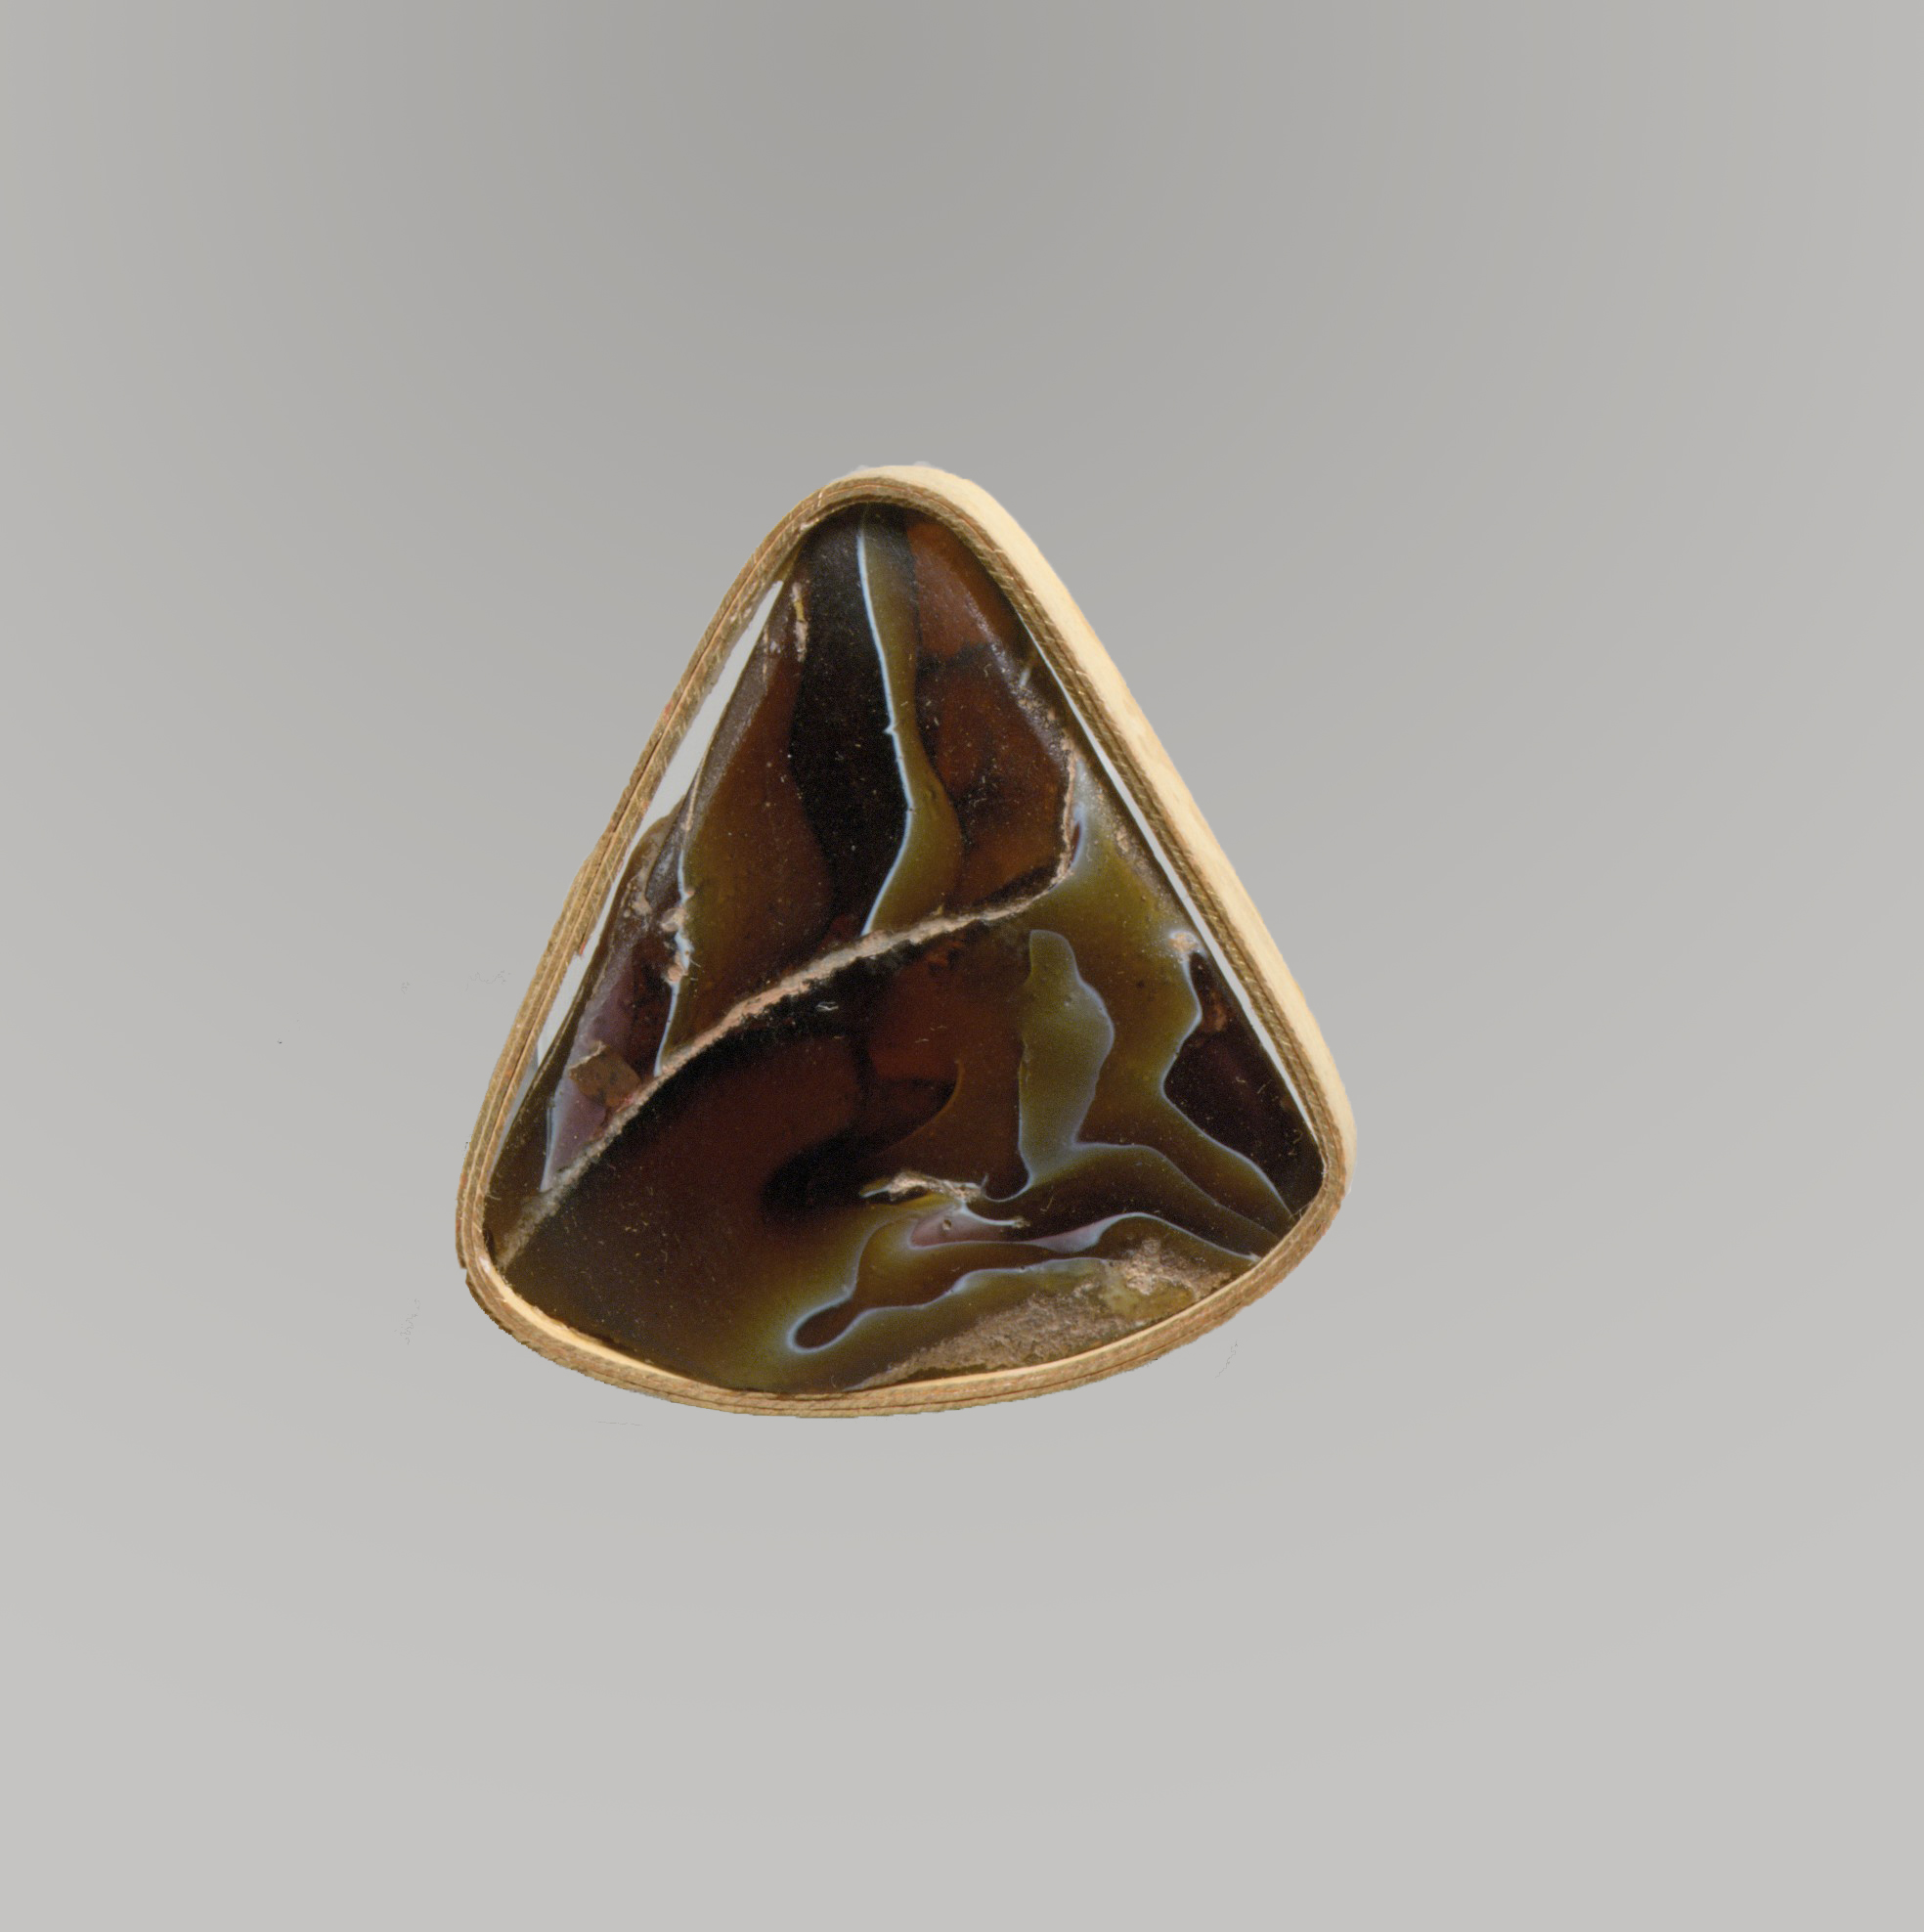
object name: mosaic bowl, fragment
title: Glass mosaic bowl fragment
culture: roman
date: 34 BCE-33 CE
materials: glass